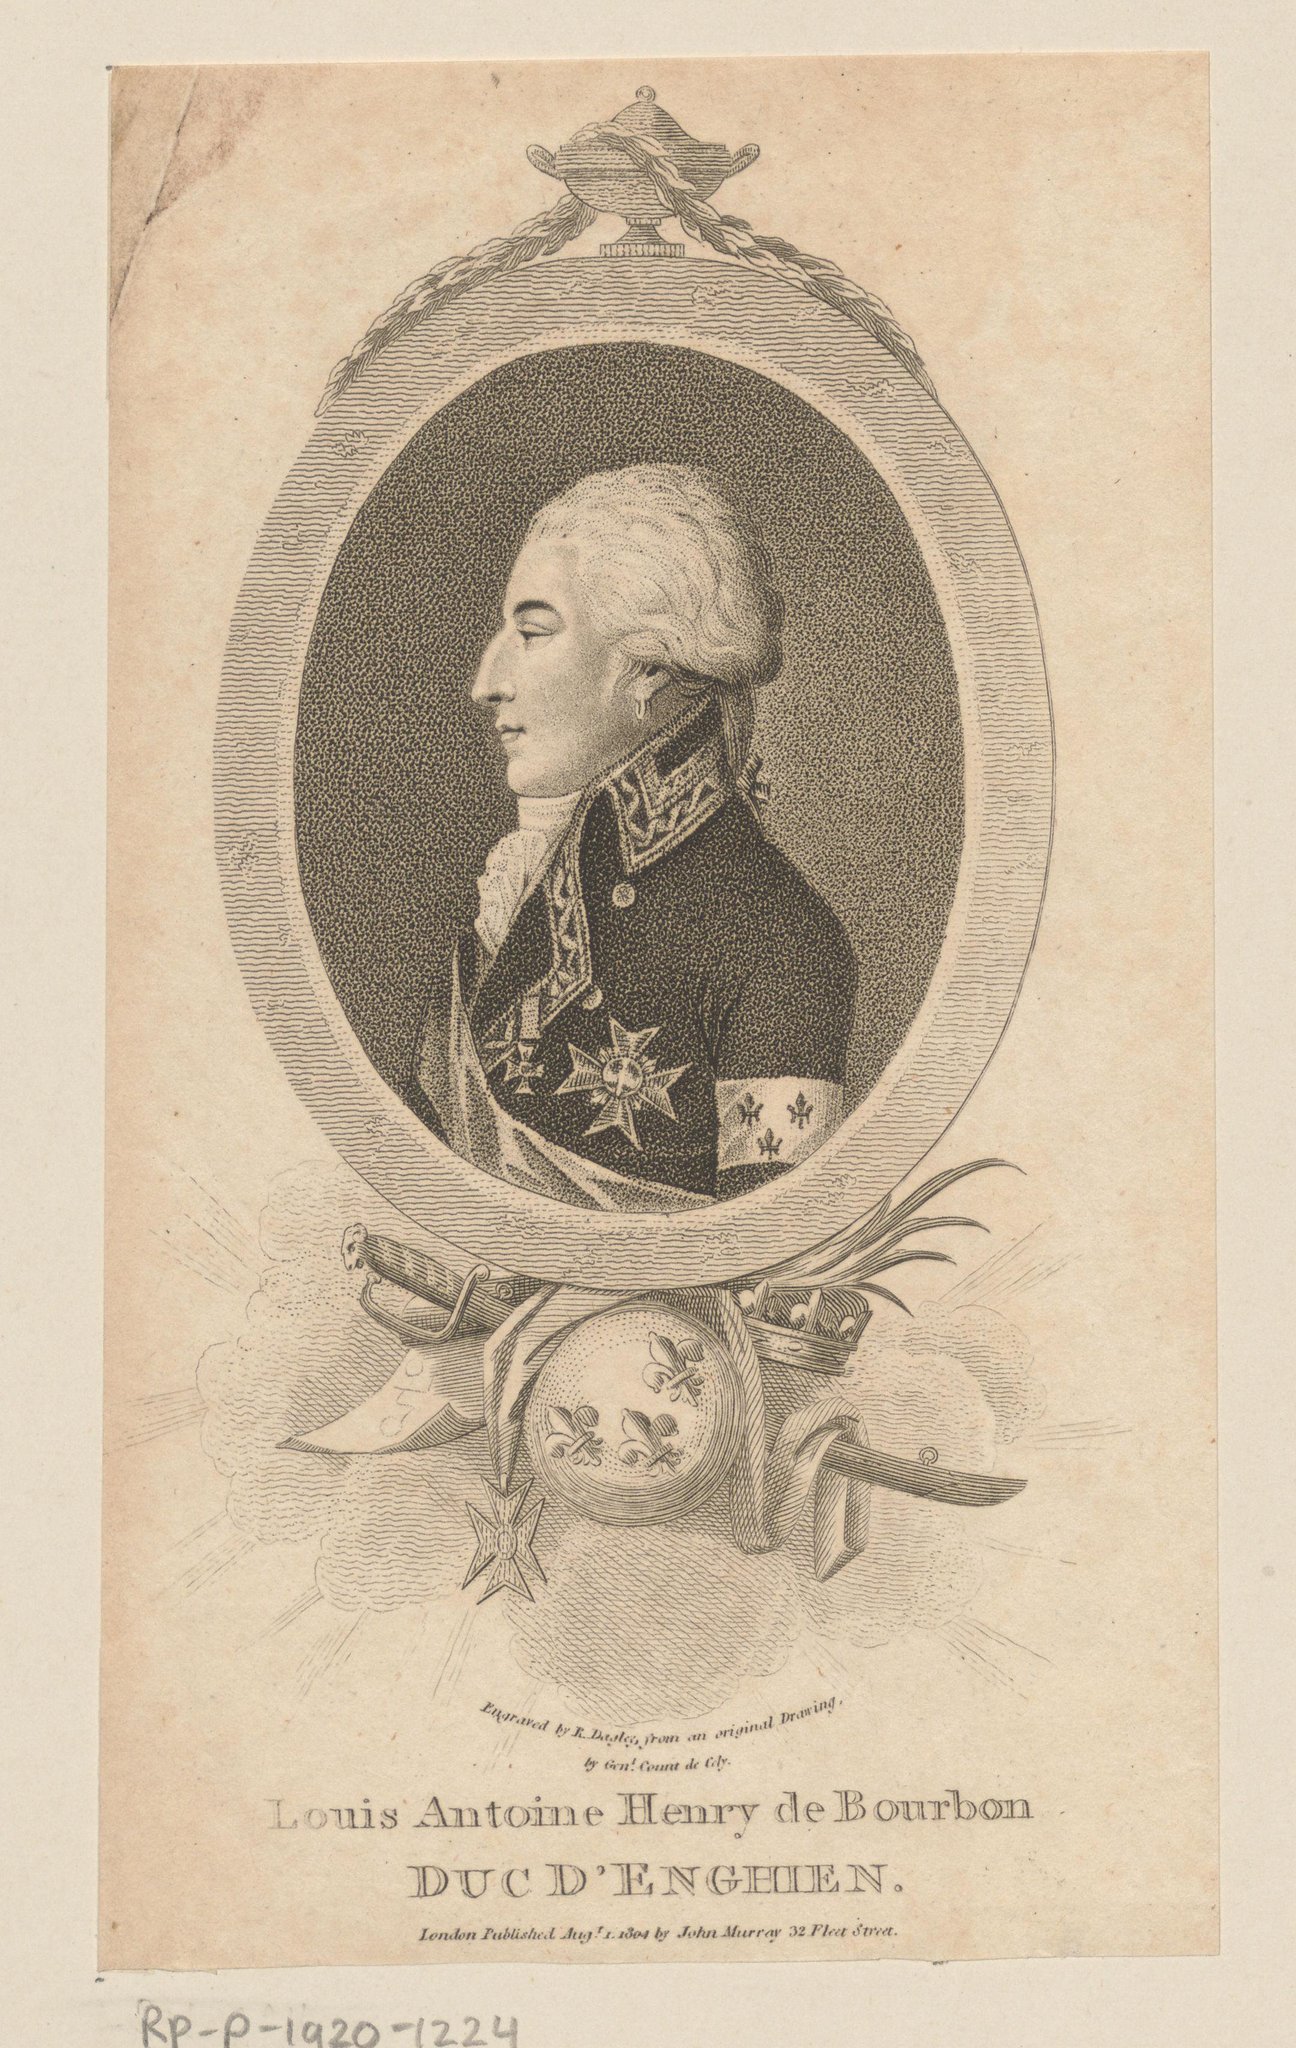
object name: print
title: Portret van Louis Antoine Henri de Bourbon-Condé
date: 1804-1808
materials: paper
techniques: etching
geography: london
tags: historical persons, hacking and thrusting weapons: sword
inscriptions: collector's mark: Lugt 2228